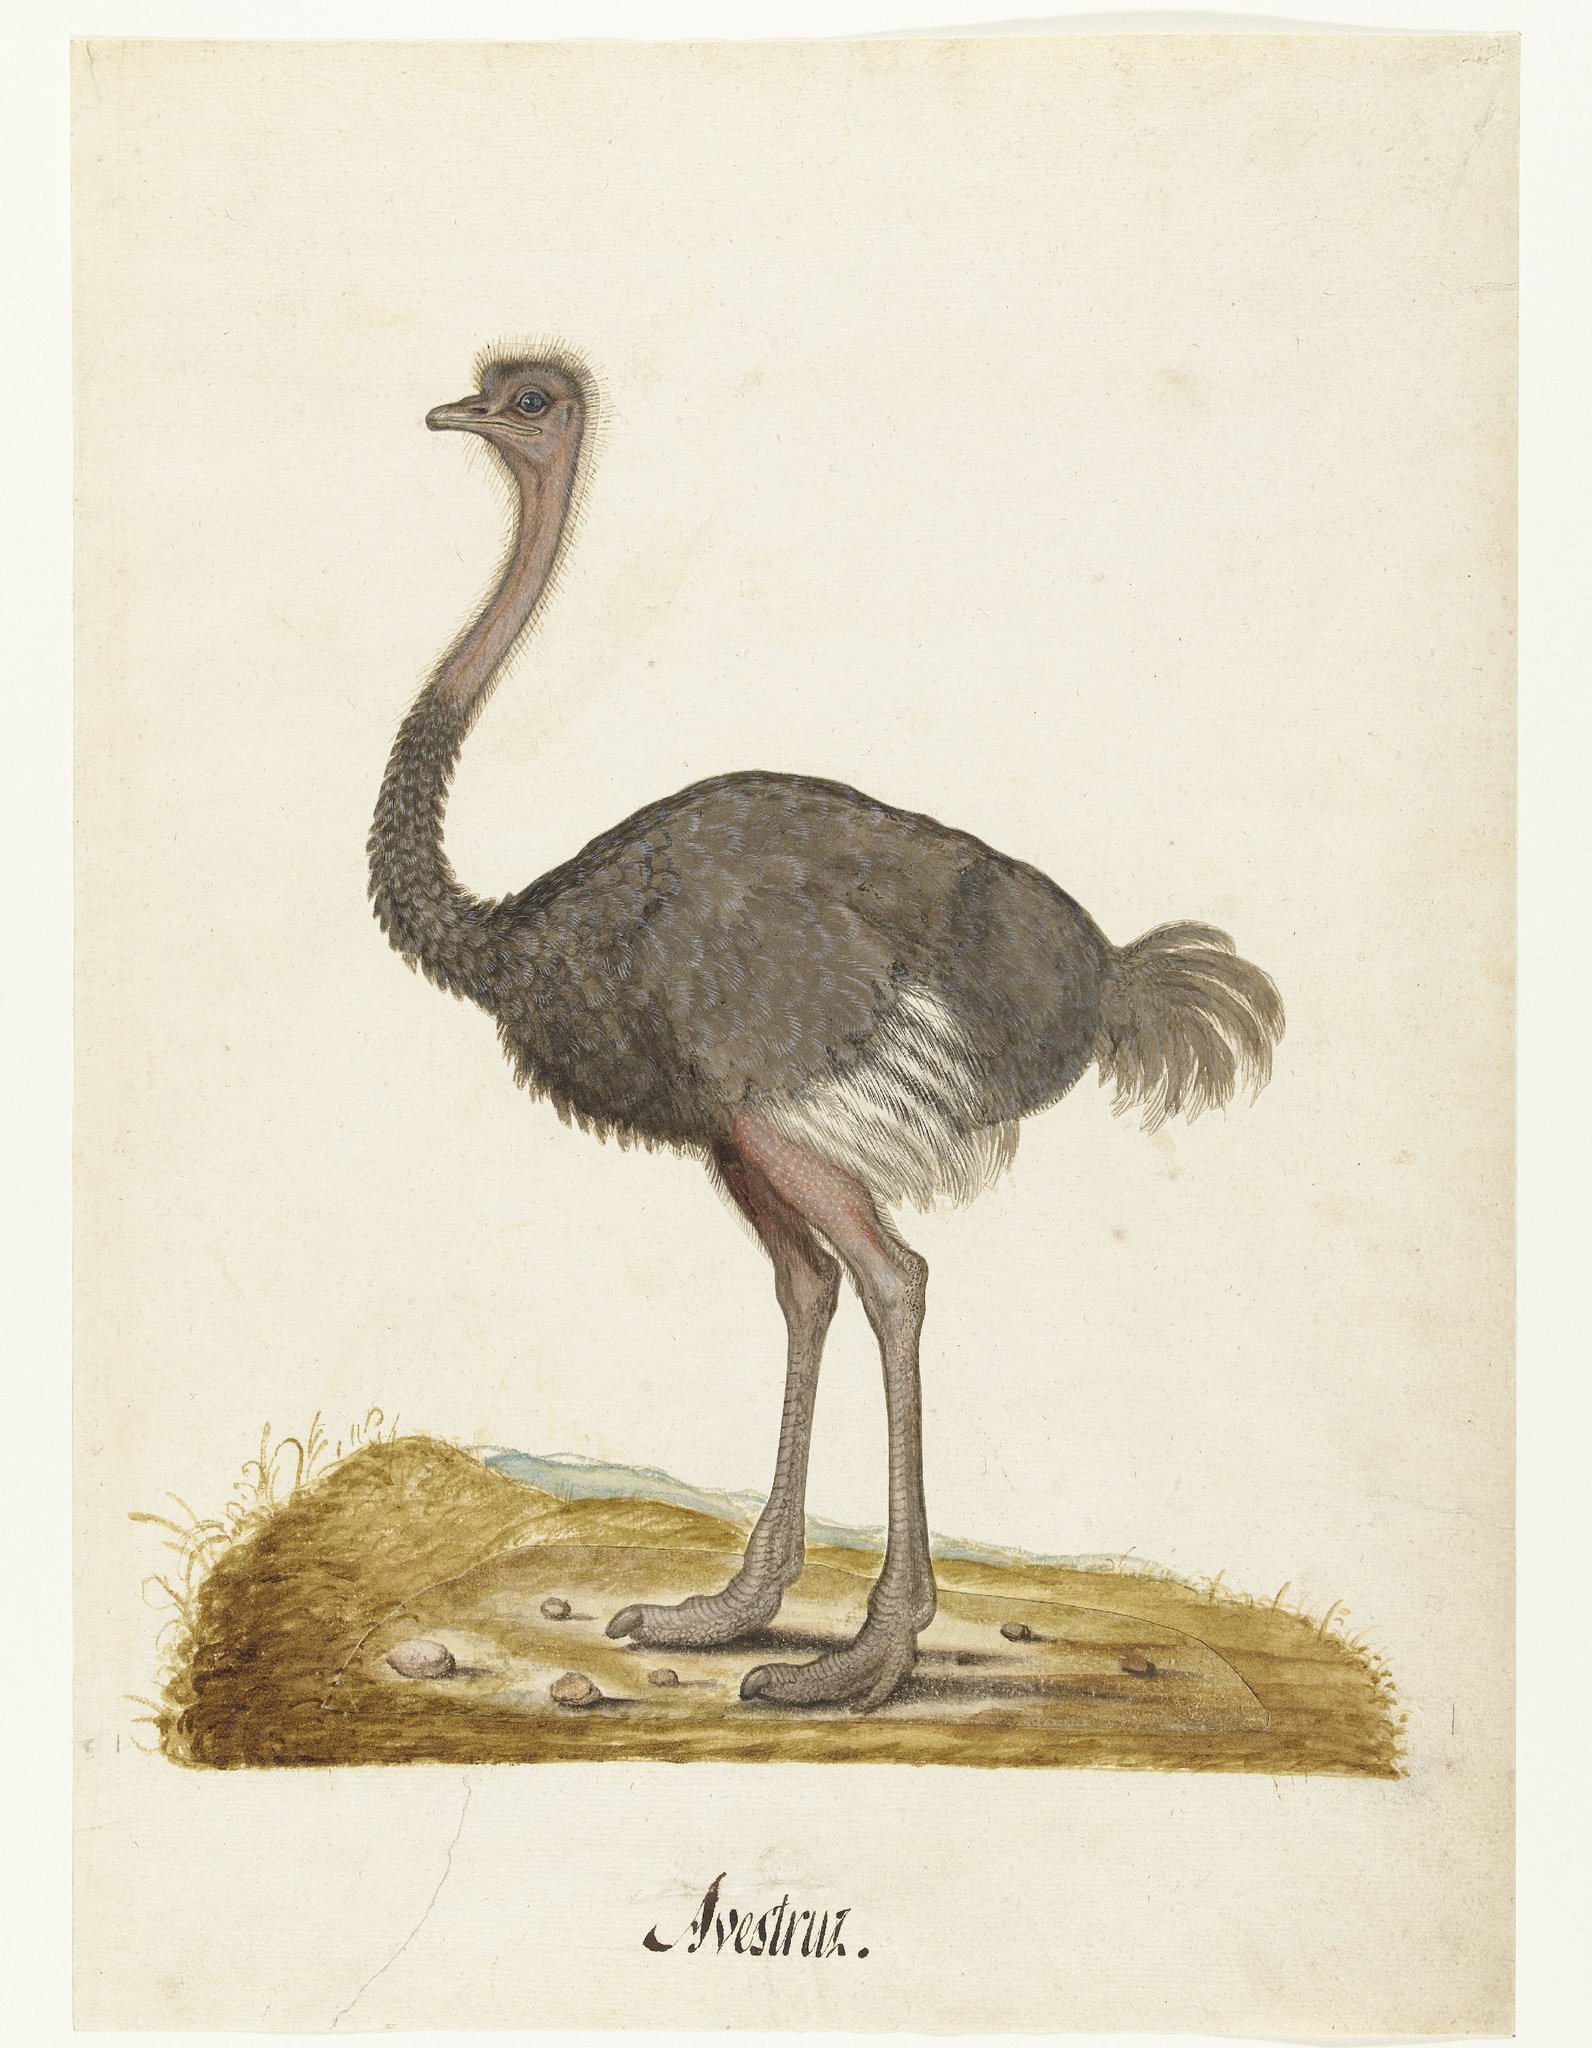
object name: drawing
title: Album Sheet with an Ostrich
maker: Anonymous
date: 1550-1570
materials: ink, paper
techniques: brush, pen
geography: low countries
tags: walker and runner birds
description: In the 16th century, artists – who had never before seen a live ostrich – sometimes made the mistake of depicting the creature flying in the sky. This artist drew the flightless bird correctly, its feet firmly planted on the ground. Details such as the bird’s finely painted downy feathers and bare goose flesh on its legs are particularly faithfully rendered.